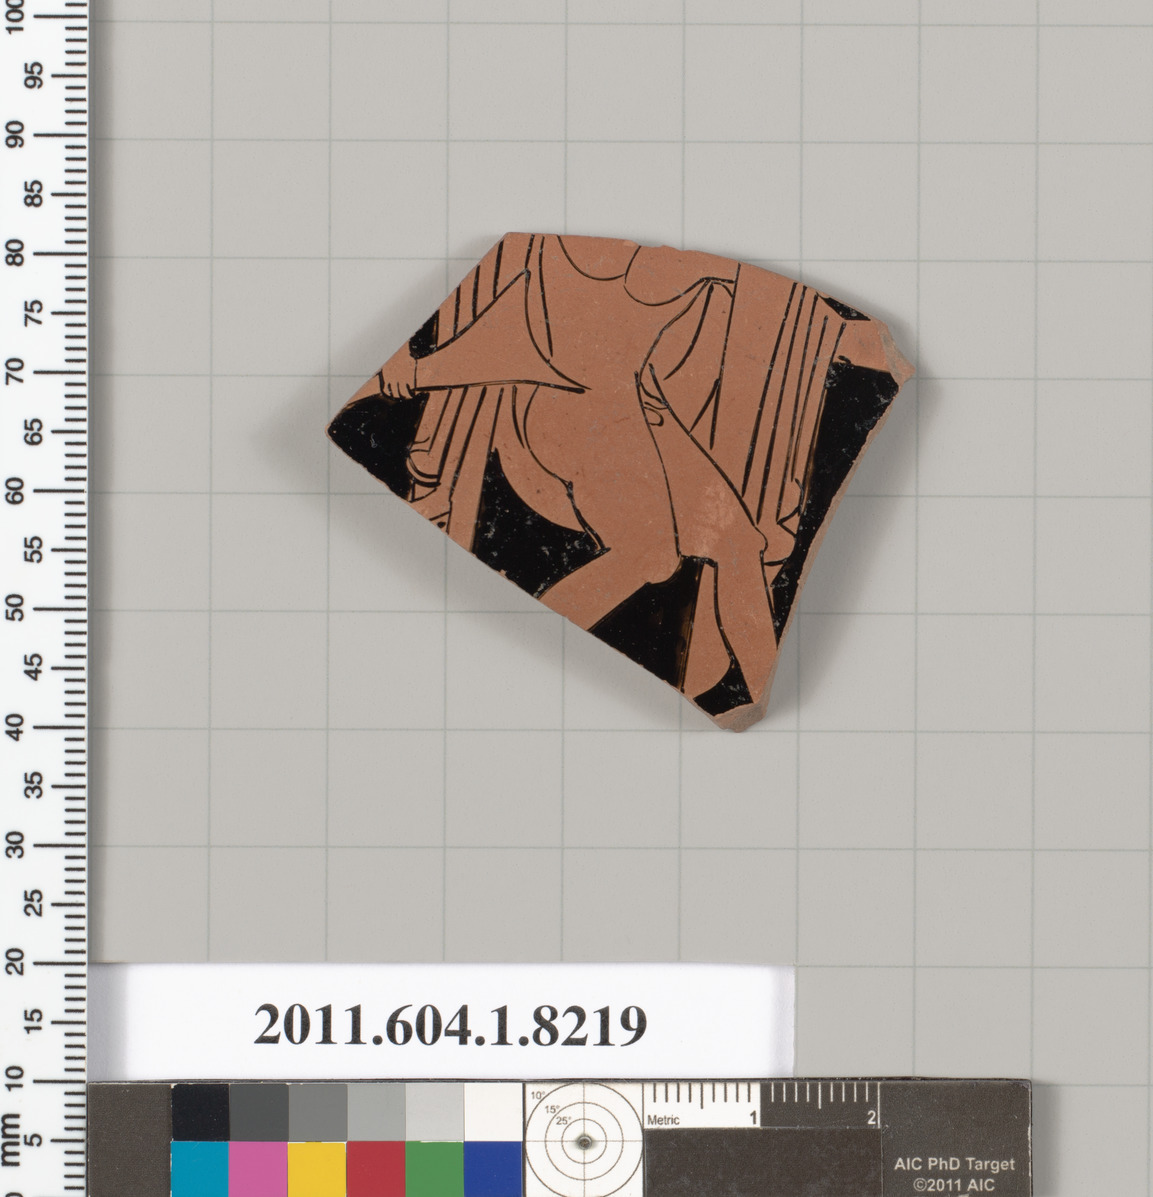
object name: kylix fragment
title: Terracotta fragment of a kylix (drinking cup)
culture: greek, attic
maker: thalia painter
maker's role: artist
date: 520-510 BCE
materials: terracotta